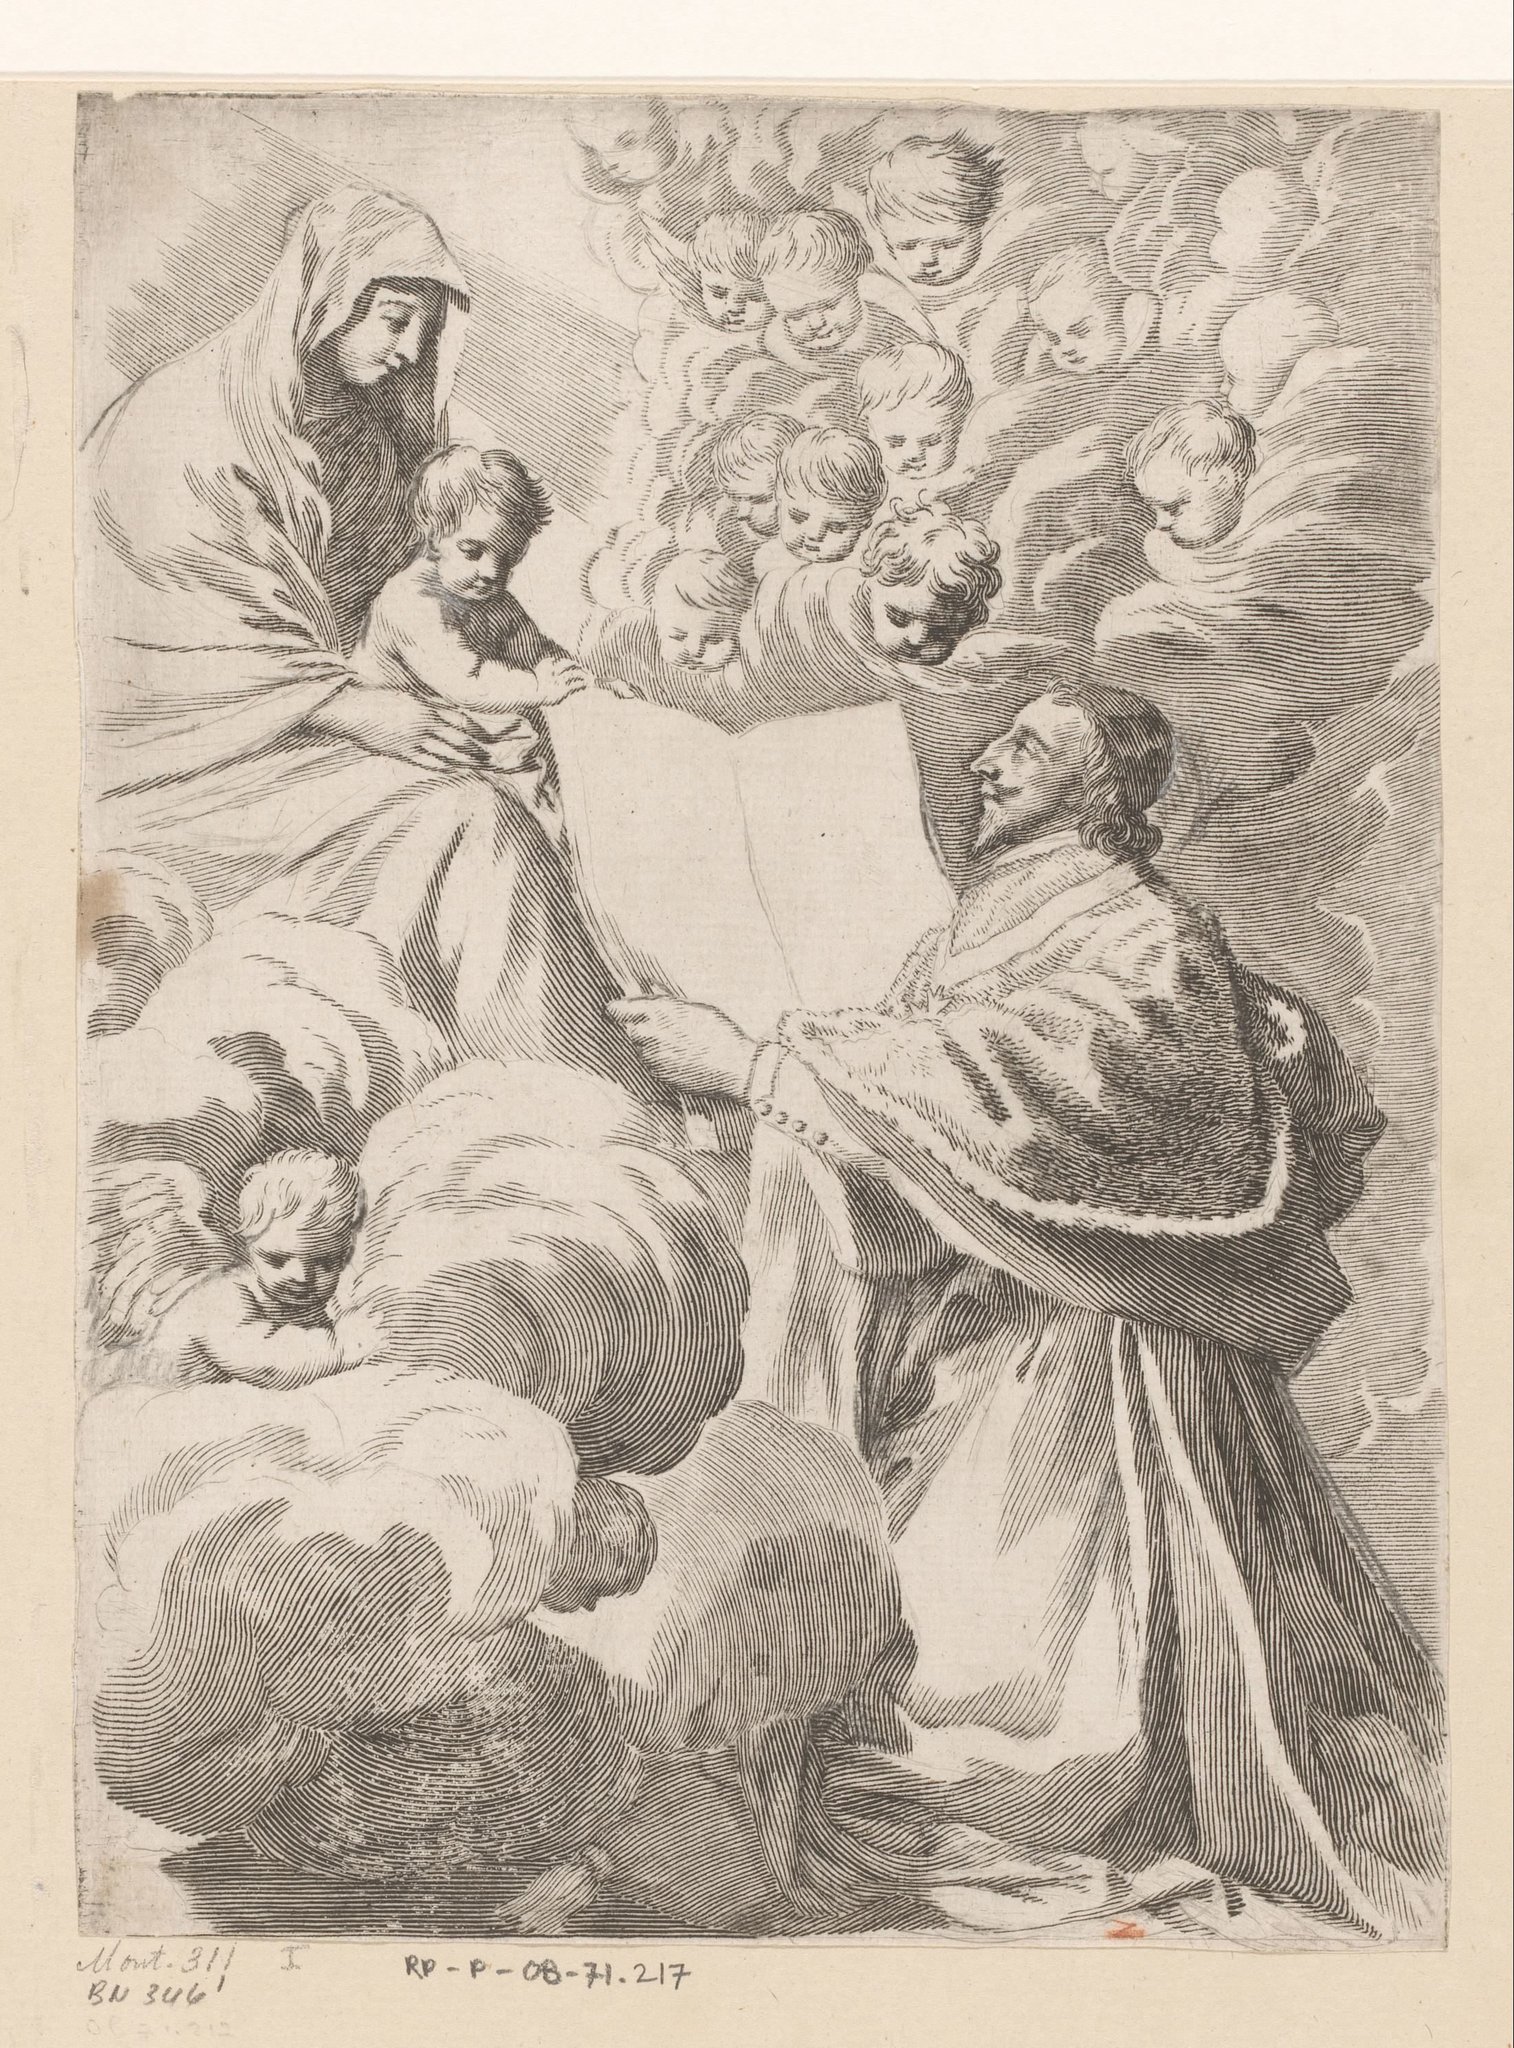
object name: titelblad, titelpagina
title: Armand-Jean du Plessis hertog van Richelieu presenteert een boek aan Maria met Kind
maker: claude mellan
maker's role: draughtsman, print maker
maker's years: 1598-1688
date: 1646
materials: paper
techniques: engraving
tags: paris, armand-jean du plessis hertog van richelieu, historical persons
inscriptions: collector's mark: Lugt 240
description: Titelpagina voor: Richelieu, Armand-Jean du Plessis hertog van. Traité de la perfection du chrétien. Parijs: Antoine Vitré, s.d.